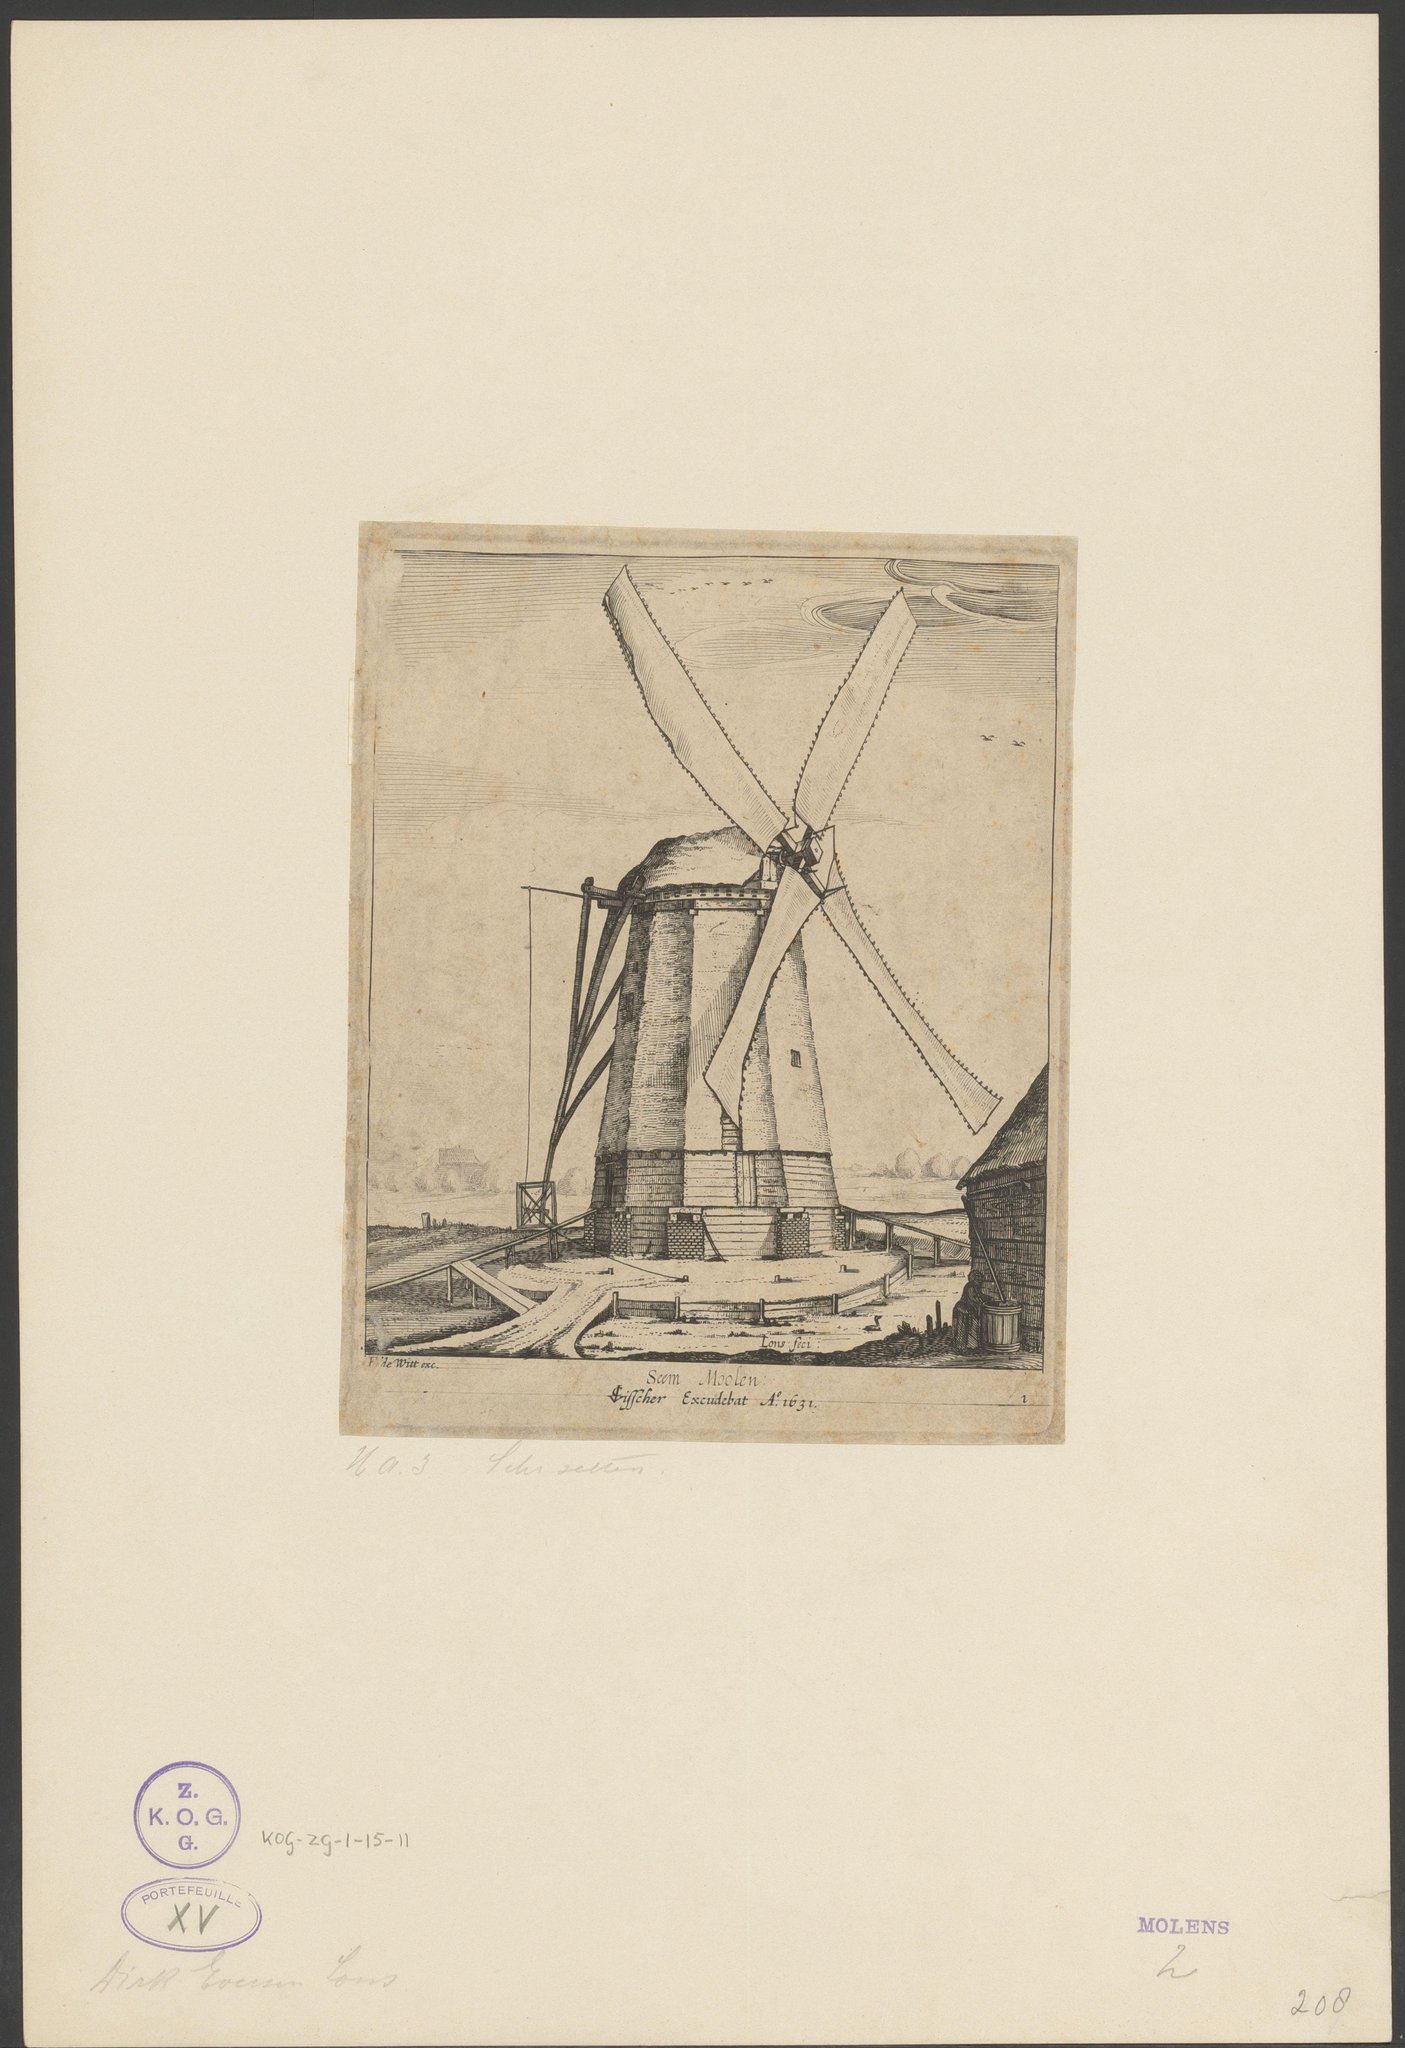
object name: print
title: Seem Moolen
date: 1631-1712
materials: paper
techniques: engraving, etching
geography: amsterdam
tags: windmill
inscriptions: collector's mark: Lugt 1641, stamp, stamp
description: Een zeem- en leermolen. Rechts op de voorgrond een figuur bij een schuur. Rechtsonder genummerd: 1. Onderwerpsrubrieken binnen de Atlas Zeden en Gewoonten: Handel, nijverheid en verkeer, Molens.